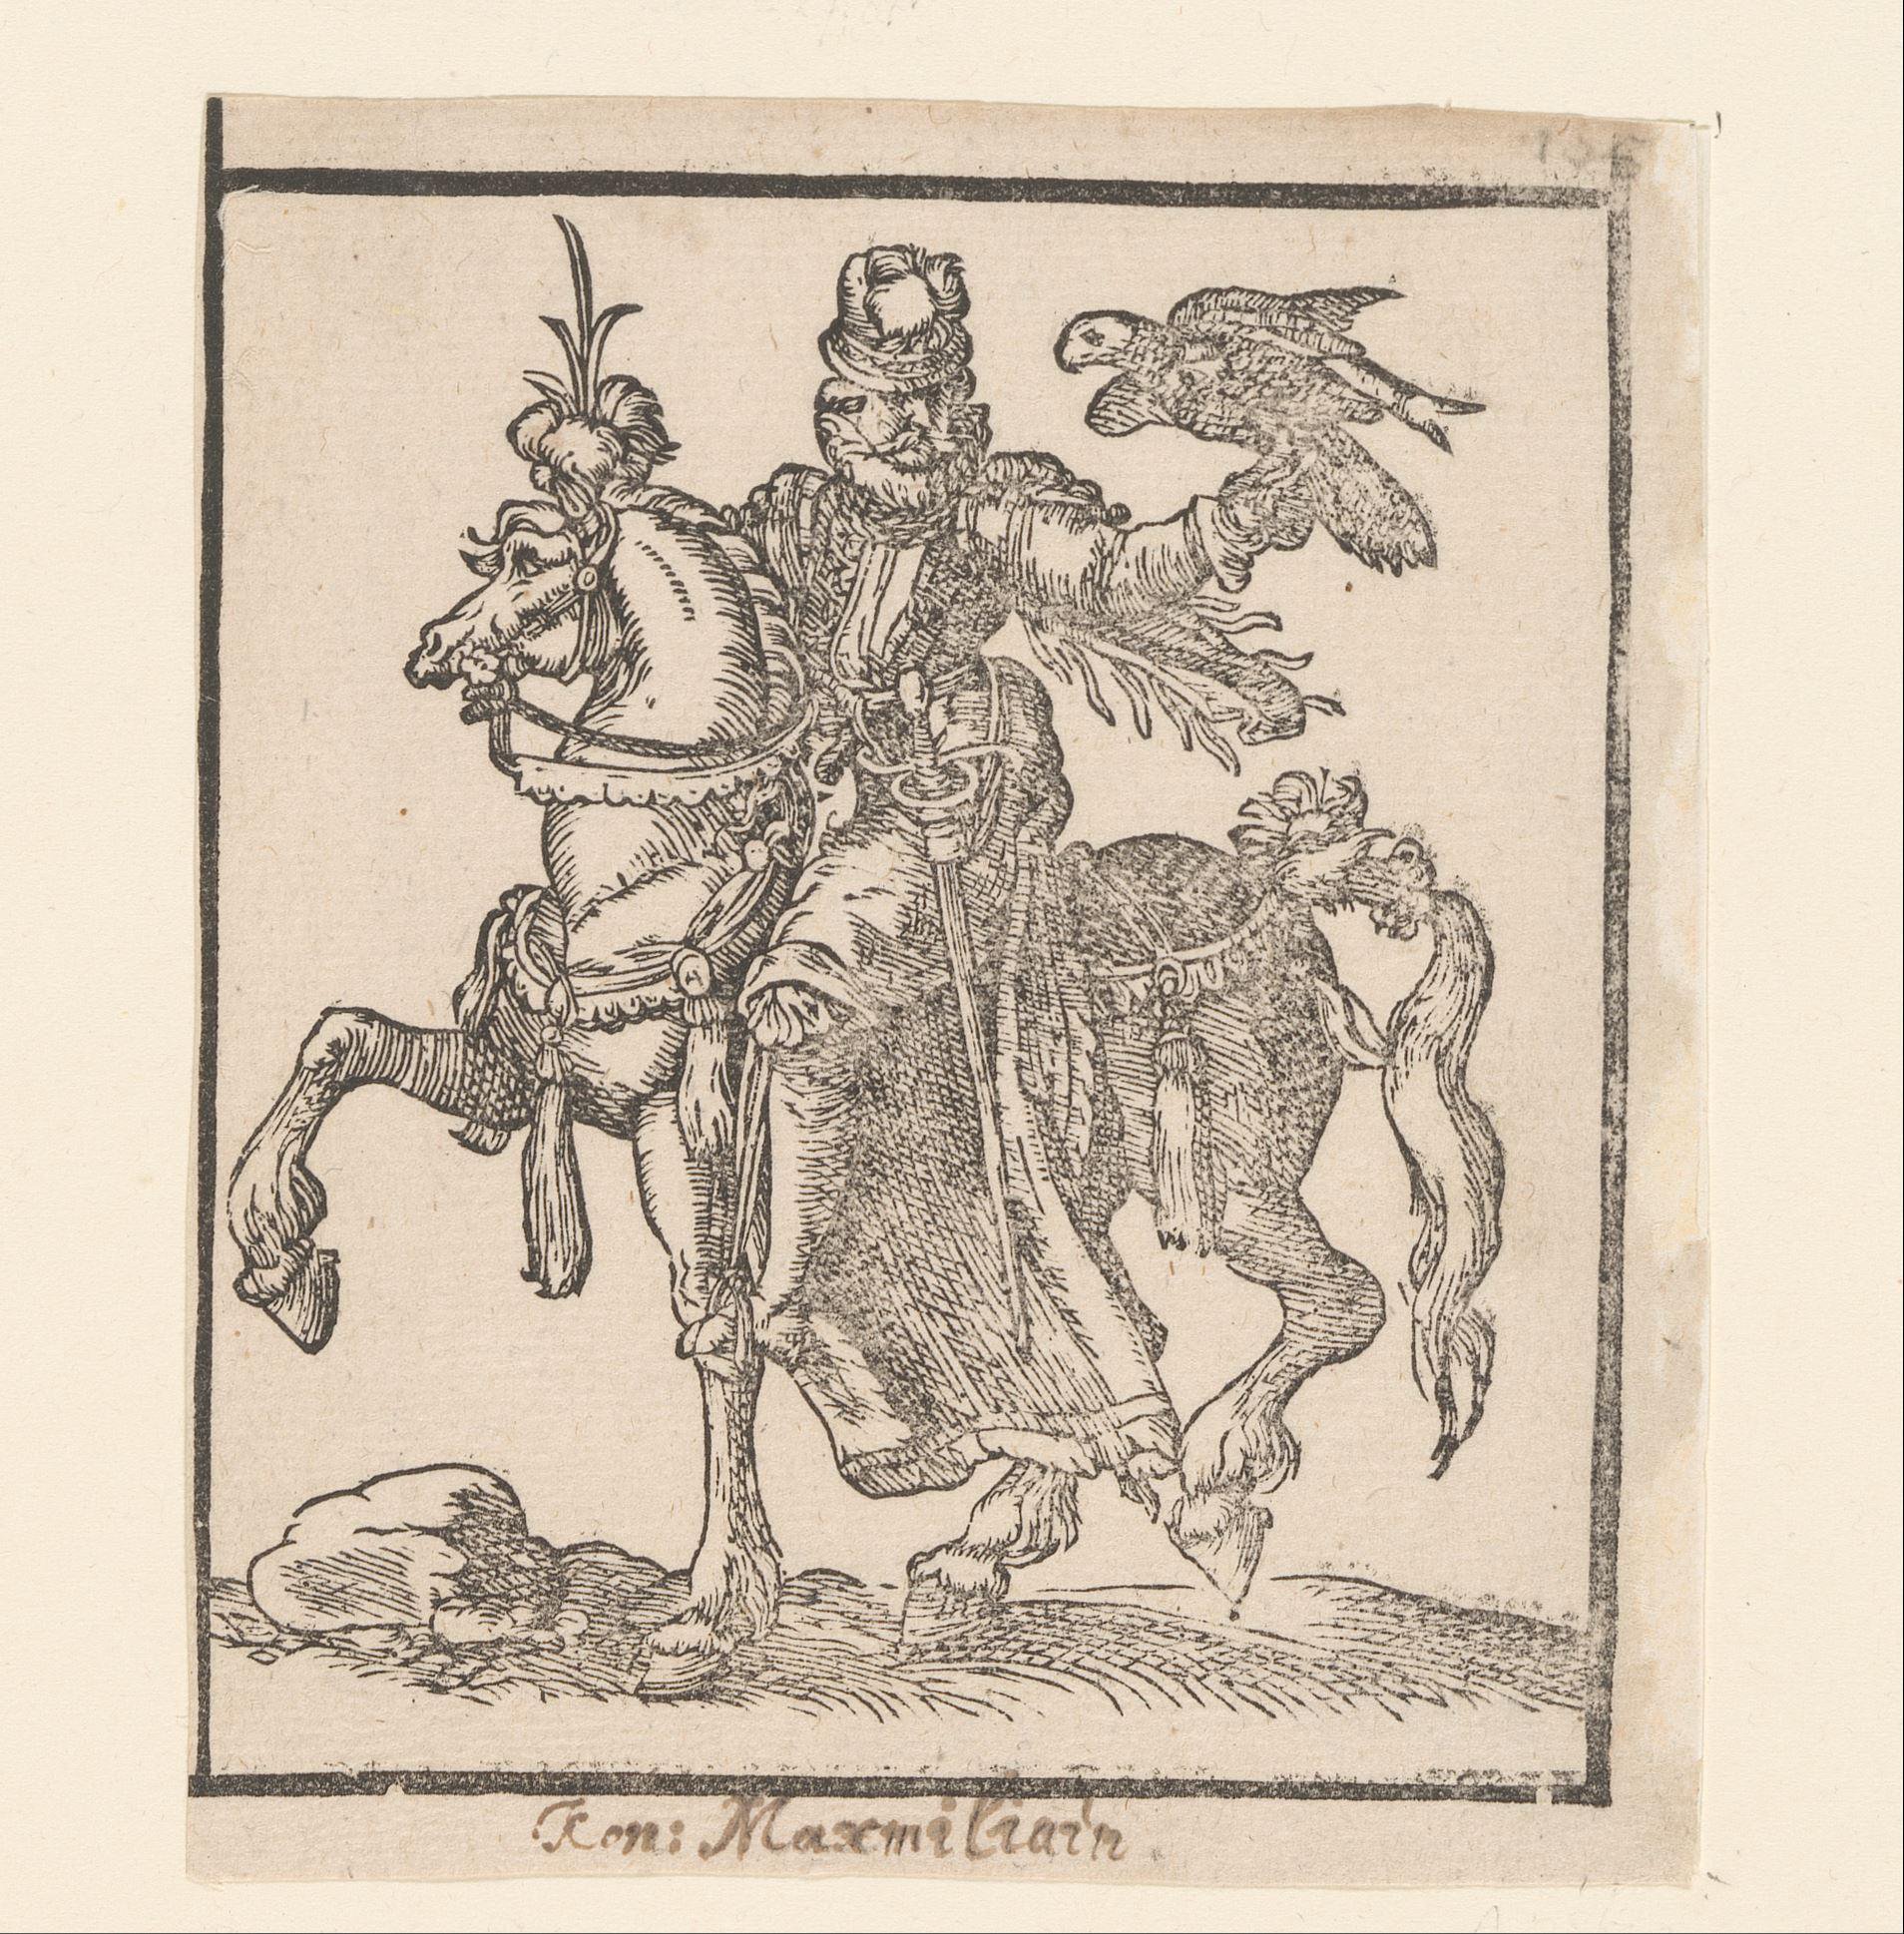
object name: print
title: Ruiter met een valk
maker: Anonymous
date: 1580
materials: paper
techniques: woodcut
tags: riding a horse, ass, or mule; rider, horseman, predatory birds: falcon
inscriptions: collector's mark: Lugt 2228, name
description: Kopie naar een prent van Jost Amman, voor het eerst uitgegeven in: Amman, Jost. Kunstbüchlein. Frankfurt am Main: Feyerabend, 1580.